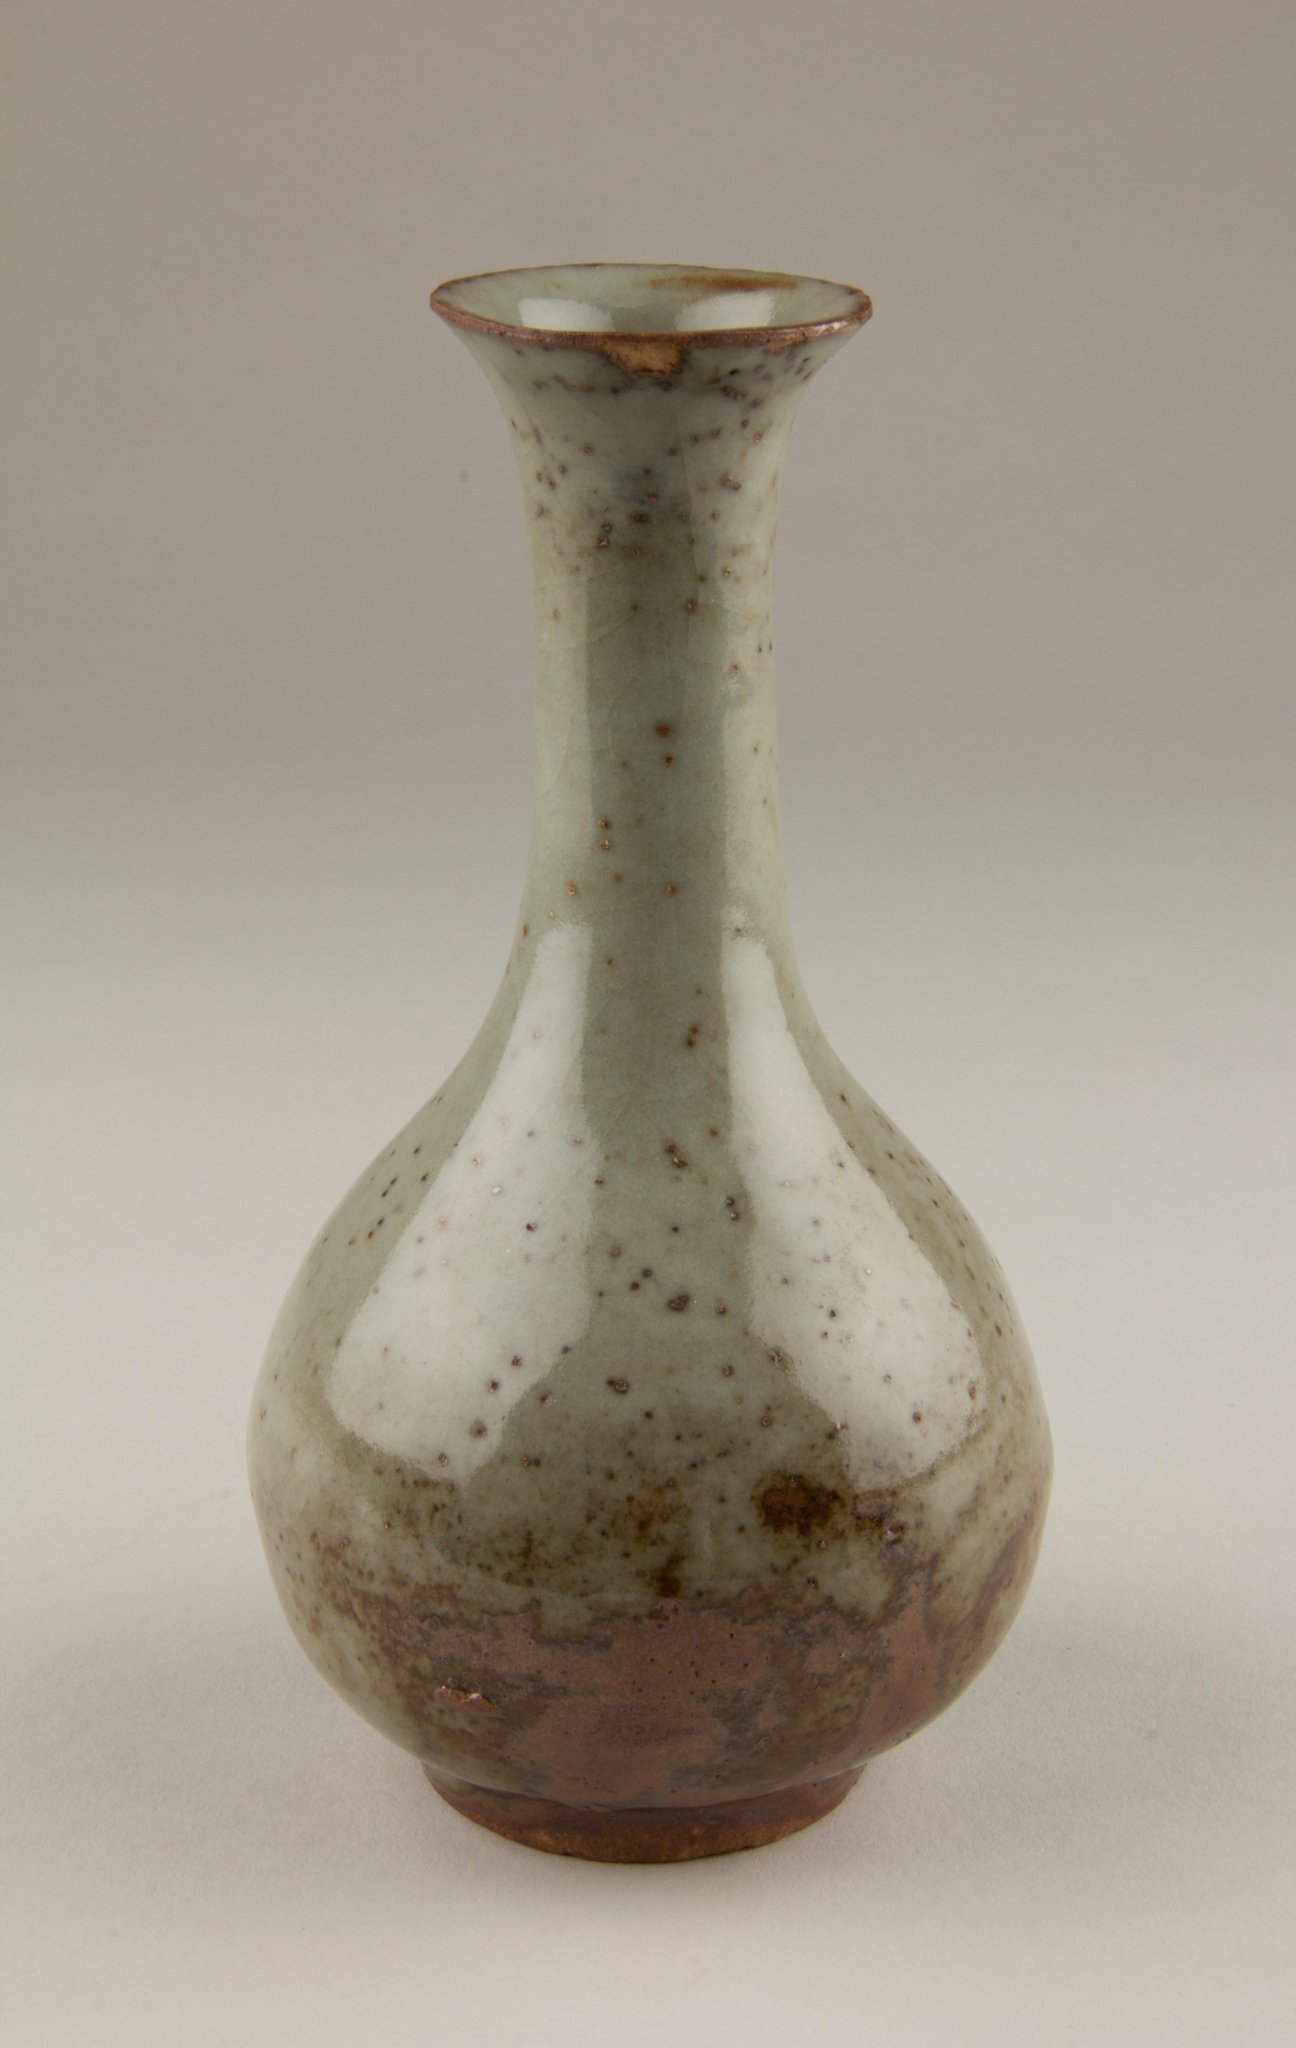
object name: vase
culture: chinese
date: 1368-1644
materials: pottery